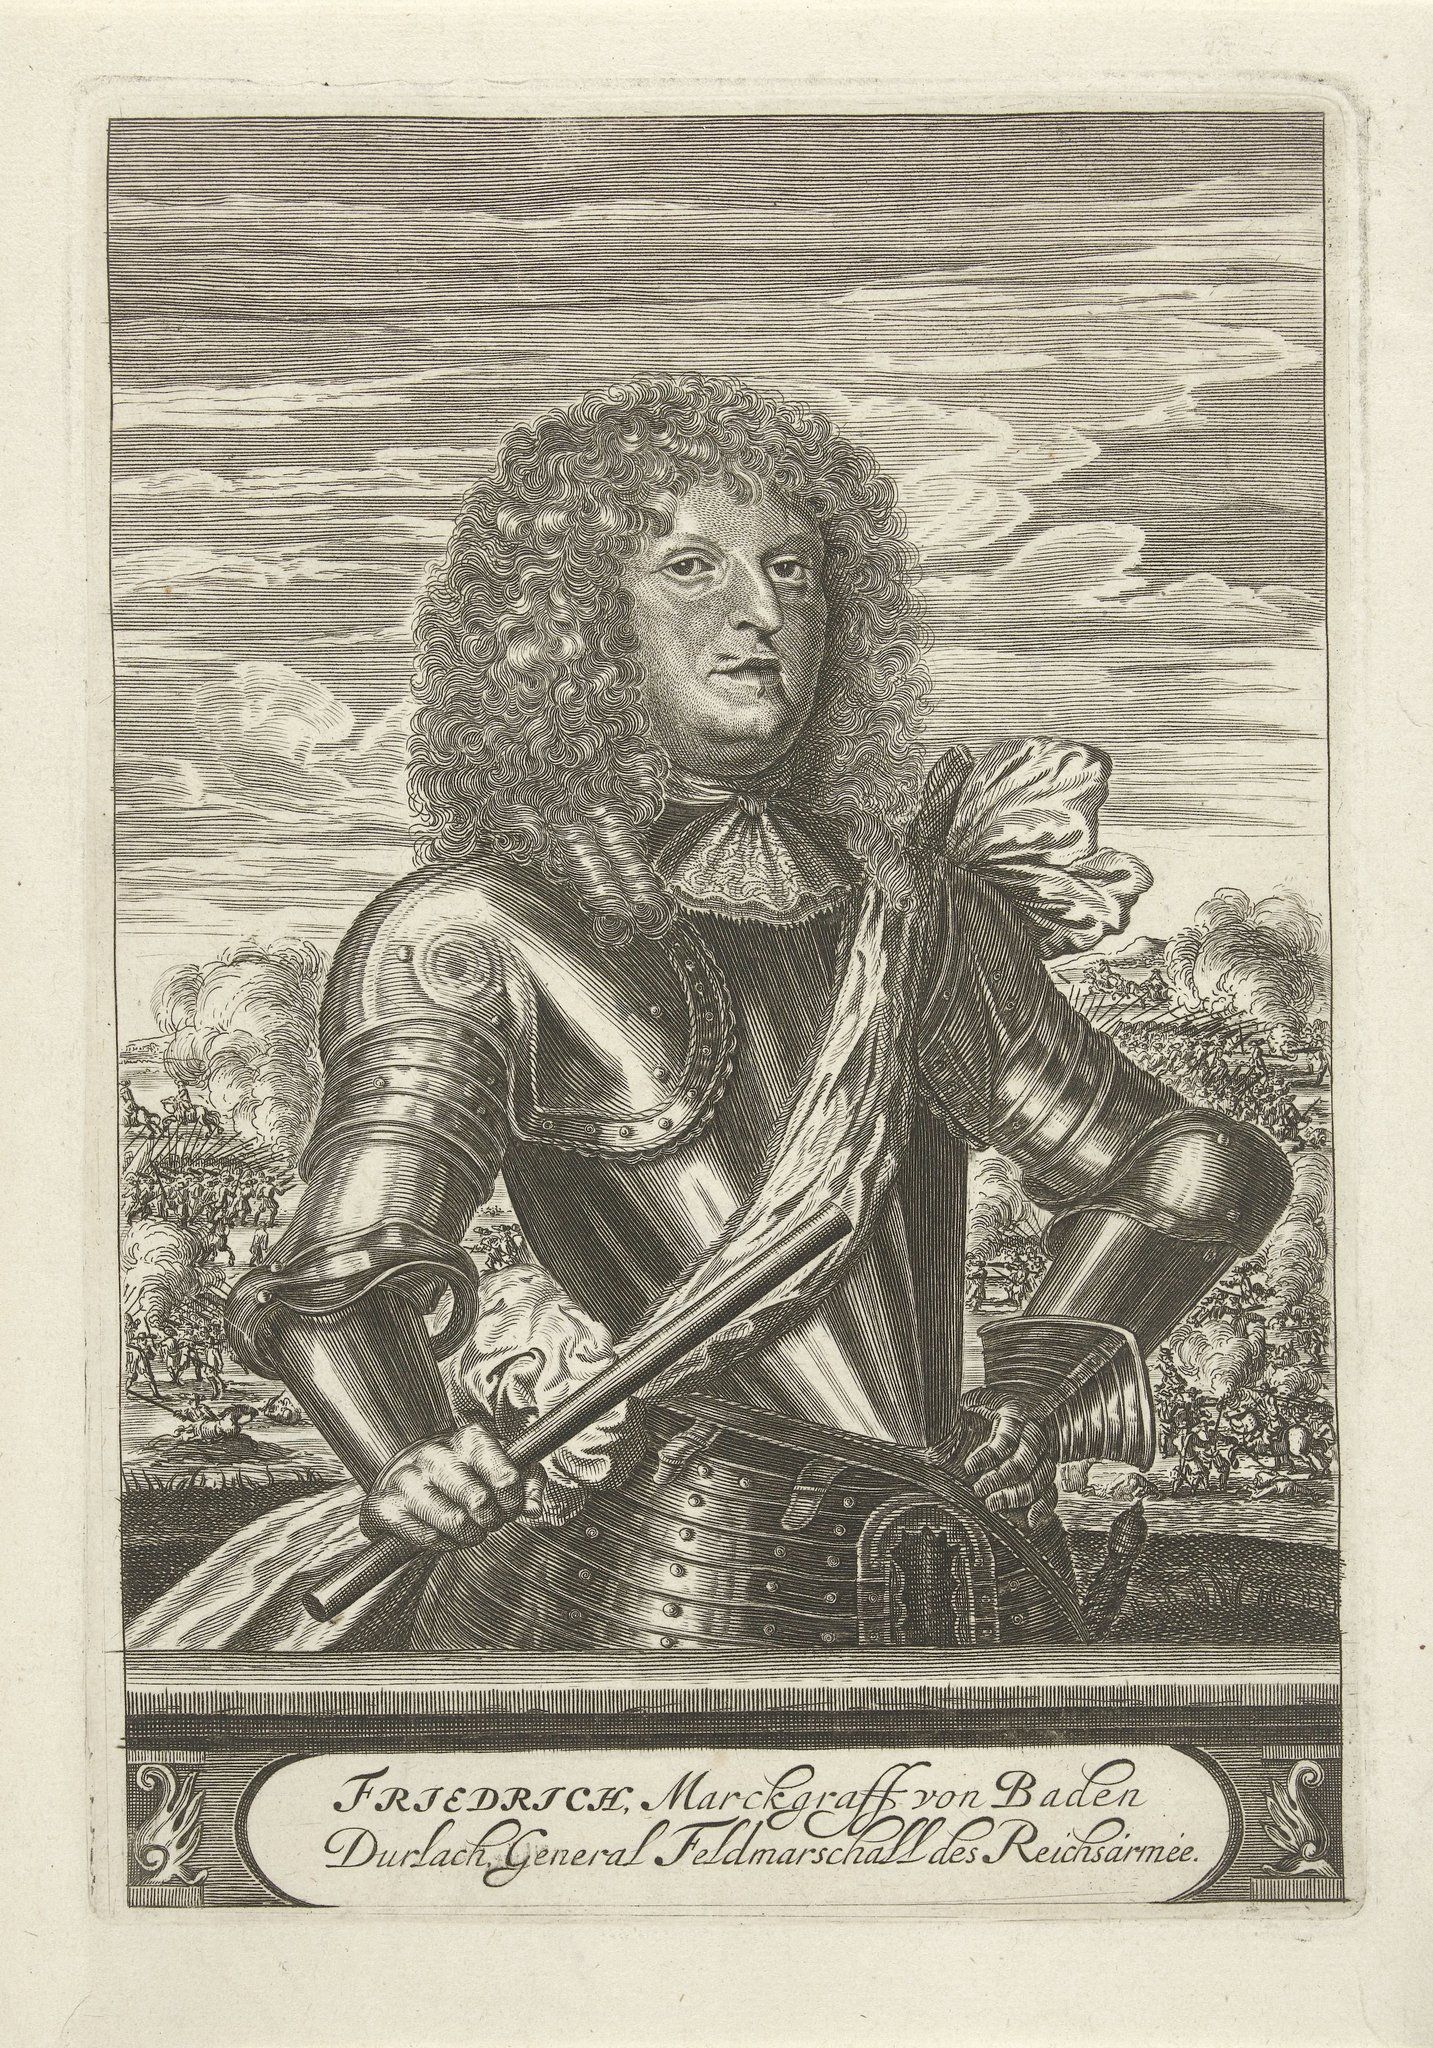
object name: print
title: Portret van Frederik IV van Baden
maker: christiaan hagen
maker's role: draughtsman, print maker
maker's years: 1635-1707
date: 1663-1695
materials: paper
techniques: engraving, etching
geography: amsterdam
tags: battle (+ cavalry, horsemen), military clothing and other equipment (uniforms, cap, armour, helmet, etc.)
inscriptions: collector's mark: Lugt 2228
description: Portret ten halven lijve naar rechts van Frederik van Baden, gekleed in een harnas waarover een sjerp. In zijn rechterhand houdt hij een commandostaf, op de achtergrond is een veldslag afgebeeld. Onder zijn portret een plint, waarop zijn naam en titel in twee regels in een cartouche.